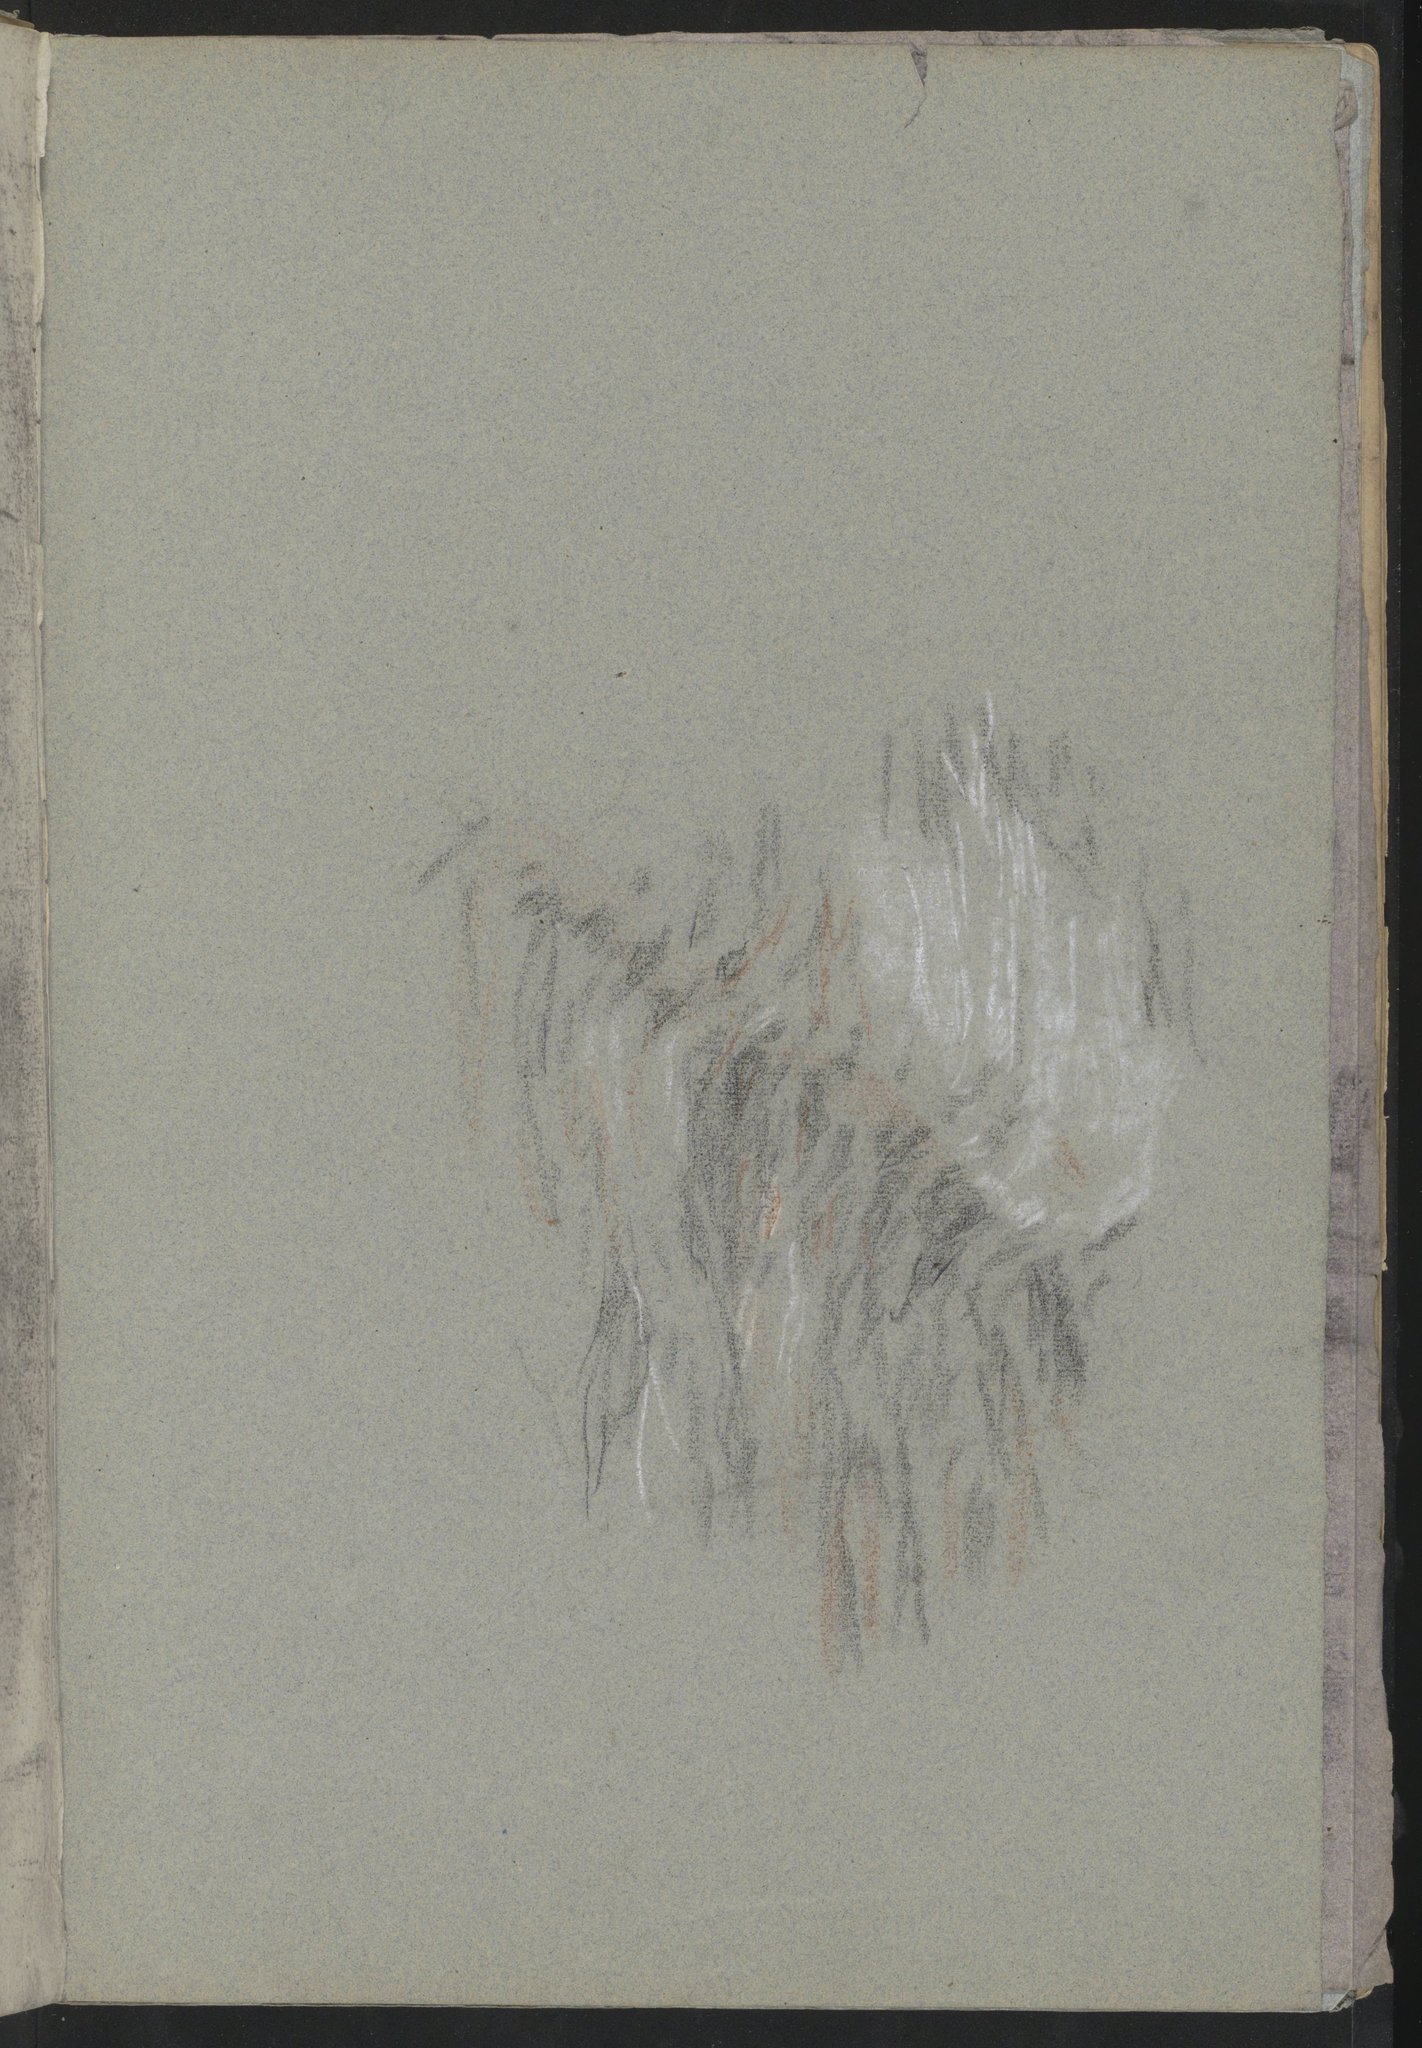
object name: sketchbook leaf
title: Studie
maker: jan veth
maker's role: designer, draughtsman, painter, print maker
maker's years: 1864-1925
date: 1874-1925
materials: chalk, paper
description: Blad 15 recto uit een schetsboek met 42 bladen.